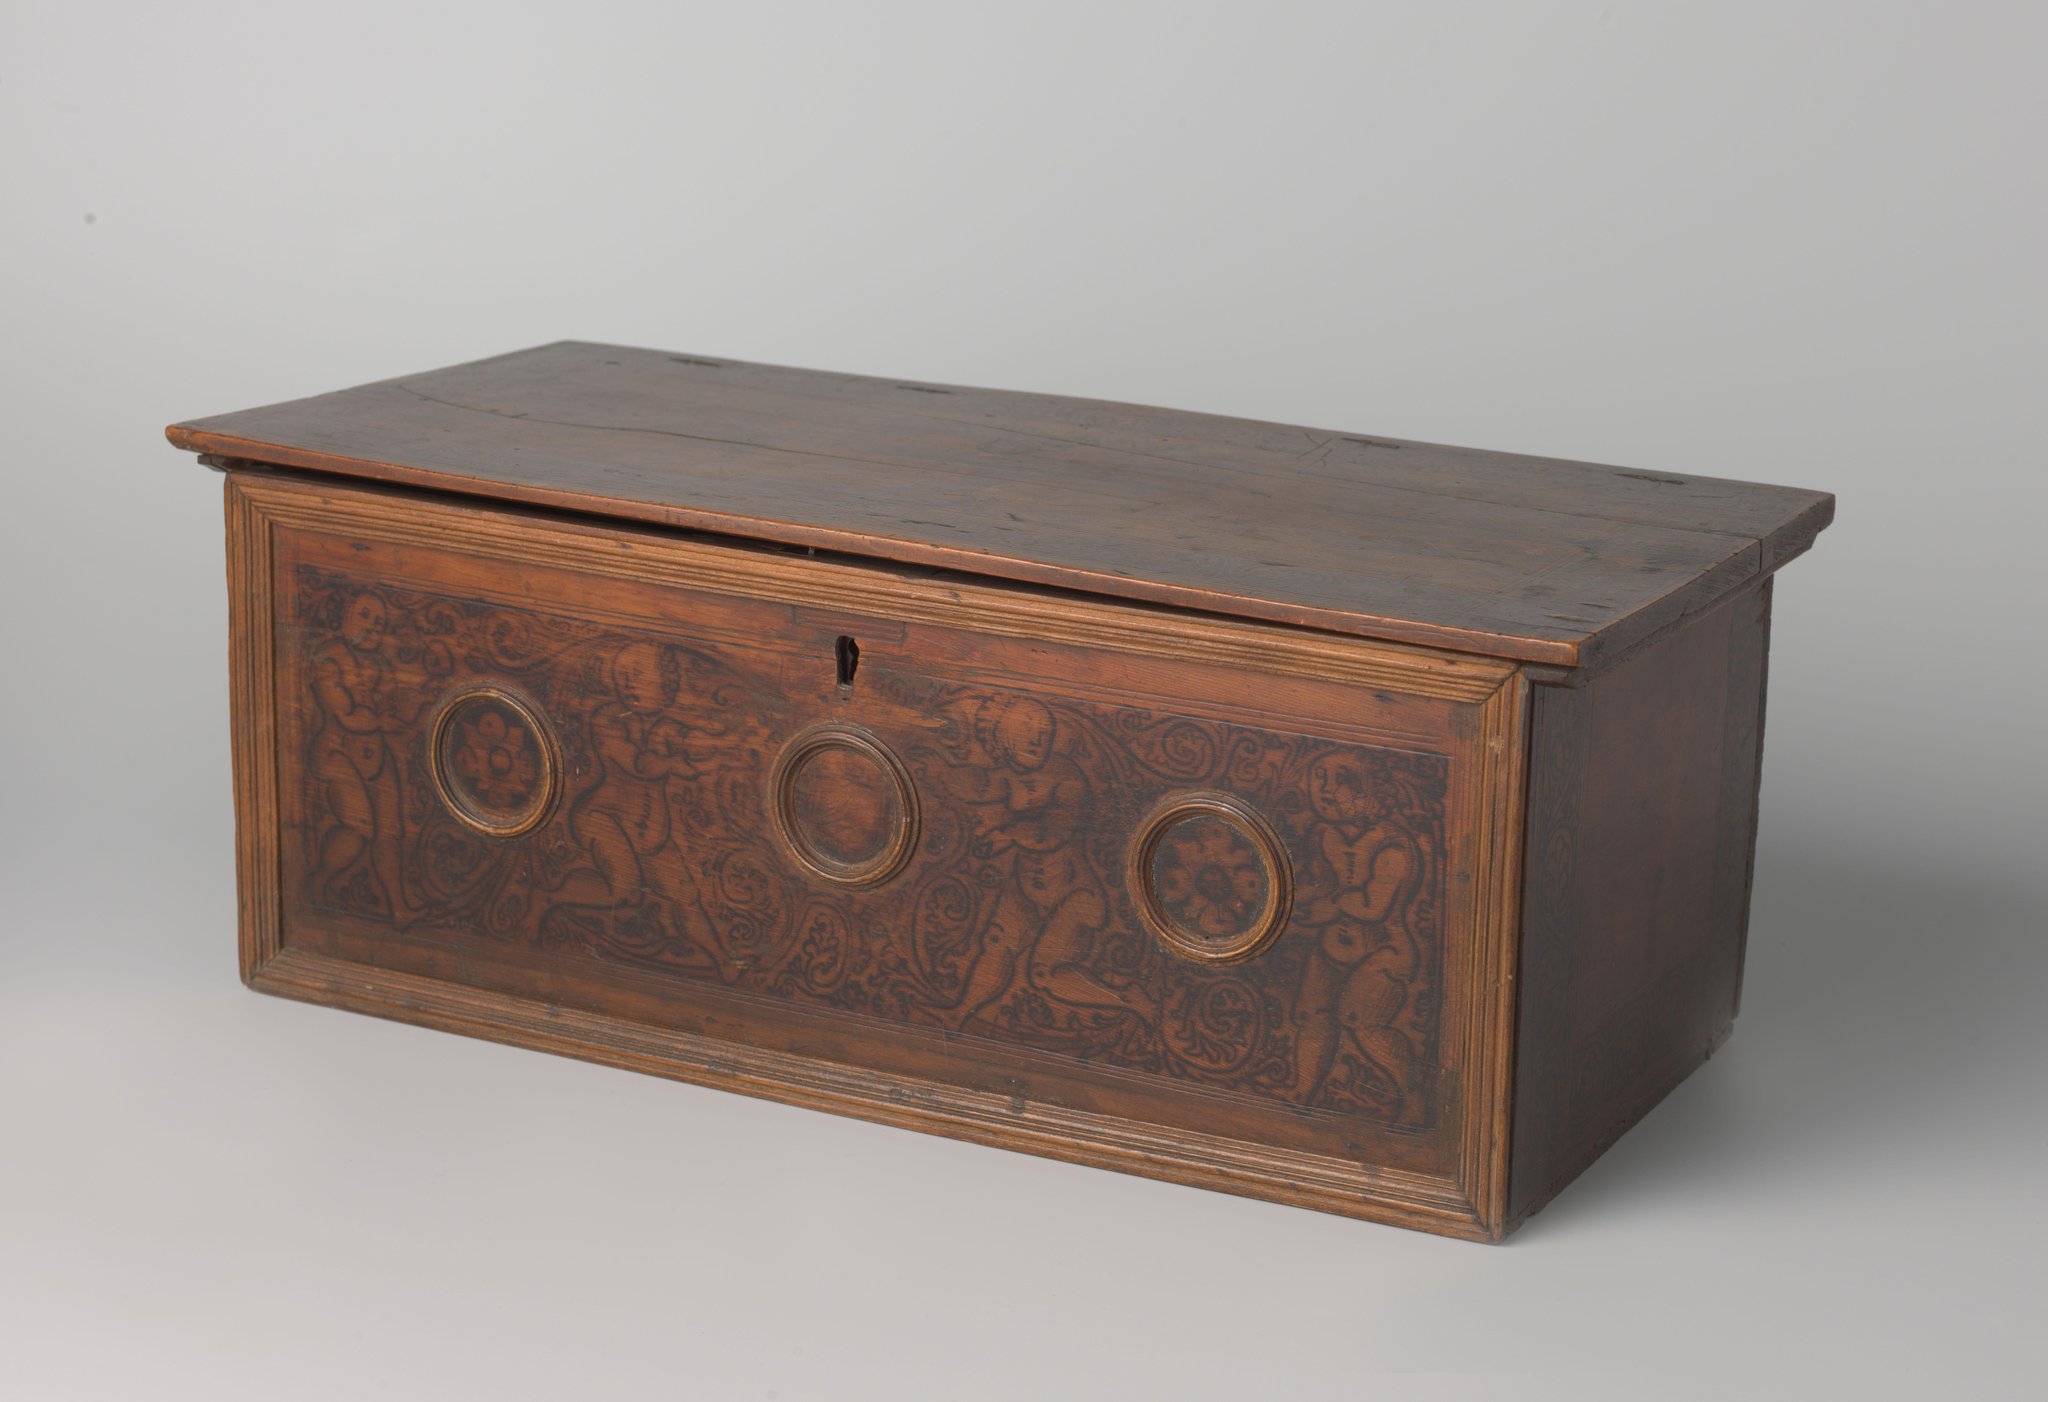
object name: furniture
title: Kist van kornoeljehout, versierd met tekeningen in Oost-Indische inkt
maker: antonio barile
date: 1500-1600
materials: wood, ink, iron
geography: italy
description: Kist van kornoeljehout. Op de voor- en zijkanten en op het deksel zijn tekeningen in Oost-Indische inkt aangebracht. De voorzijde vertoont vier putti temidden van bladranken, afgewisseld door rozetten binnen geprofileerde cirkels en het deksel vertoont twee adelaars in vlucht ter weerszijden van een boom. De rand van het deksel draagt, evenals de zijkanten, een rankenmotief in Oost-Indische inkt. Links ter halve hoogte heeft de kist een vakje.